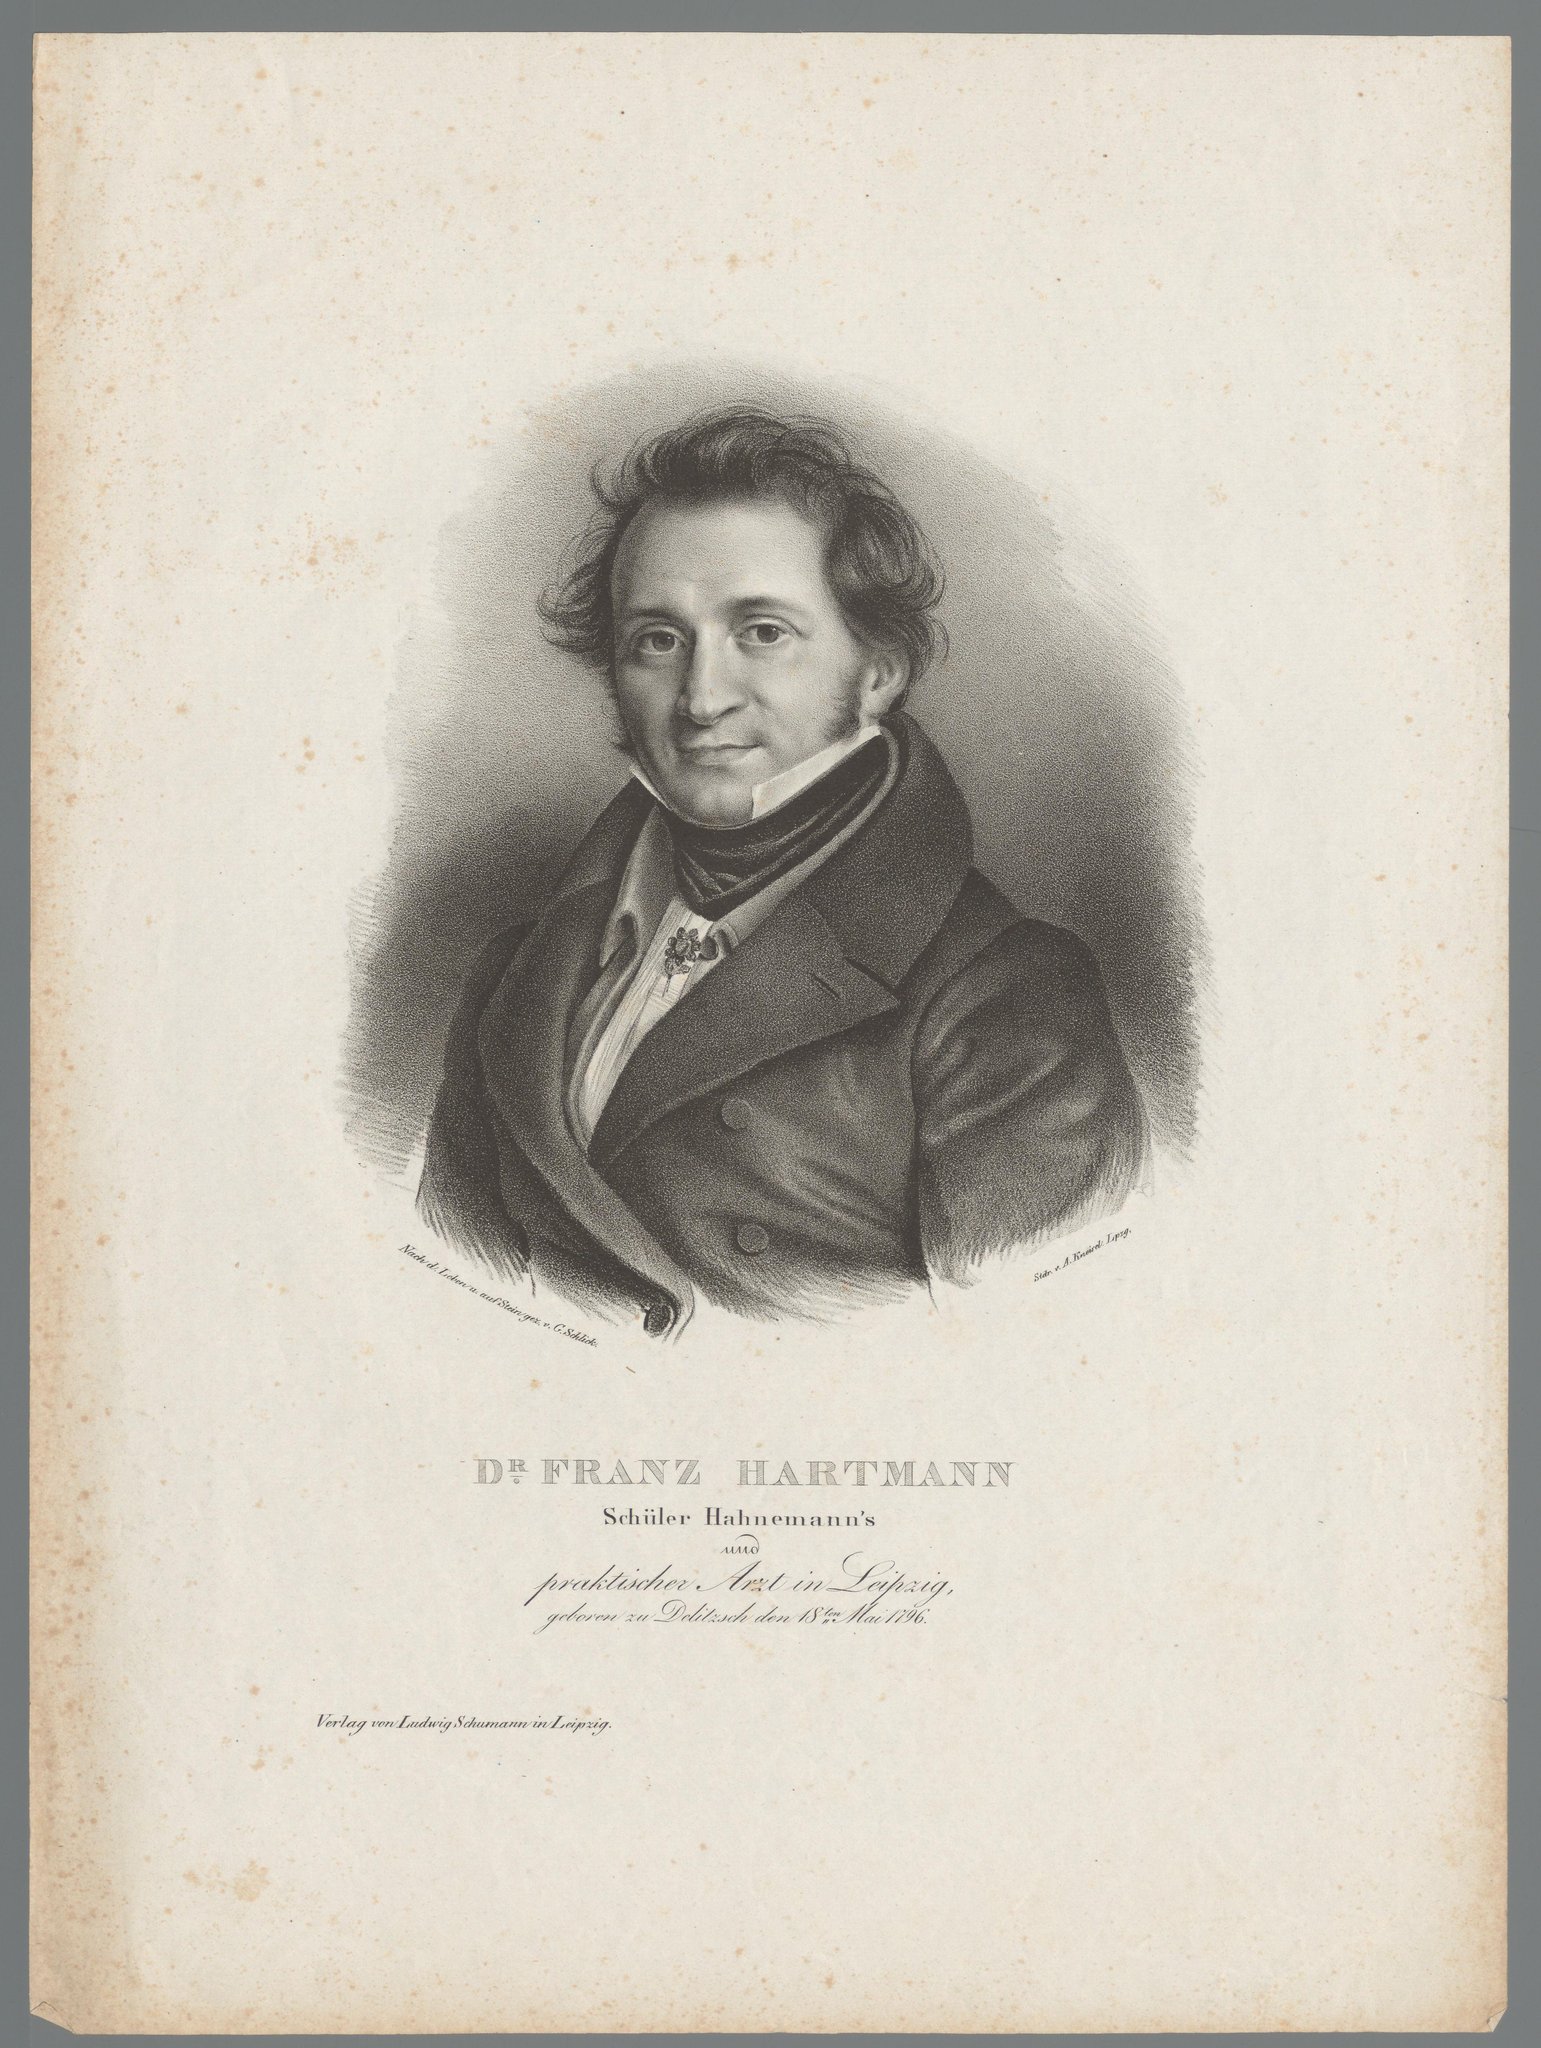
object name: print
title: Portret van Franz Hartmann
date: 1814-1855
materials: paper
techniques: lithograph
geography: leipzig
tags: historical persons, physician, doctor (+ portrait of scholar, scientist)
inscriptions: collector's mark: Lugt 2228